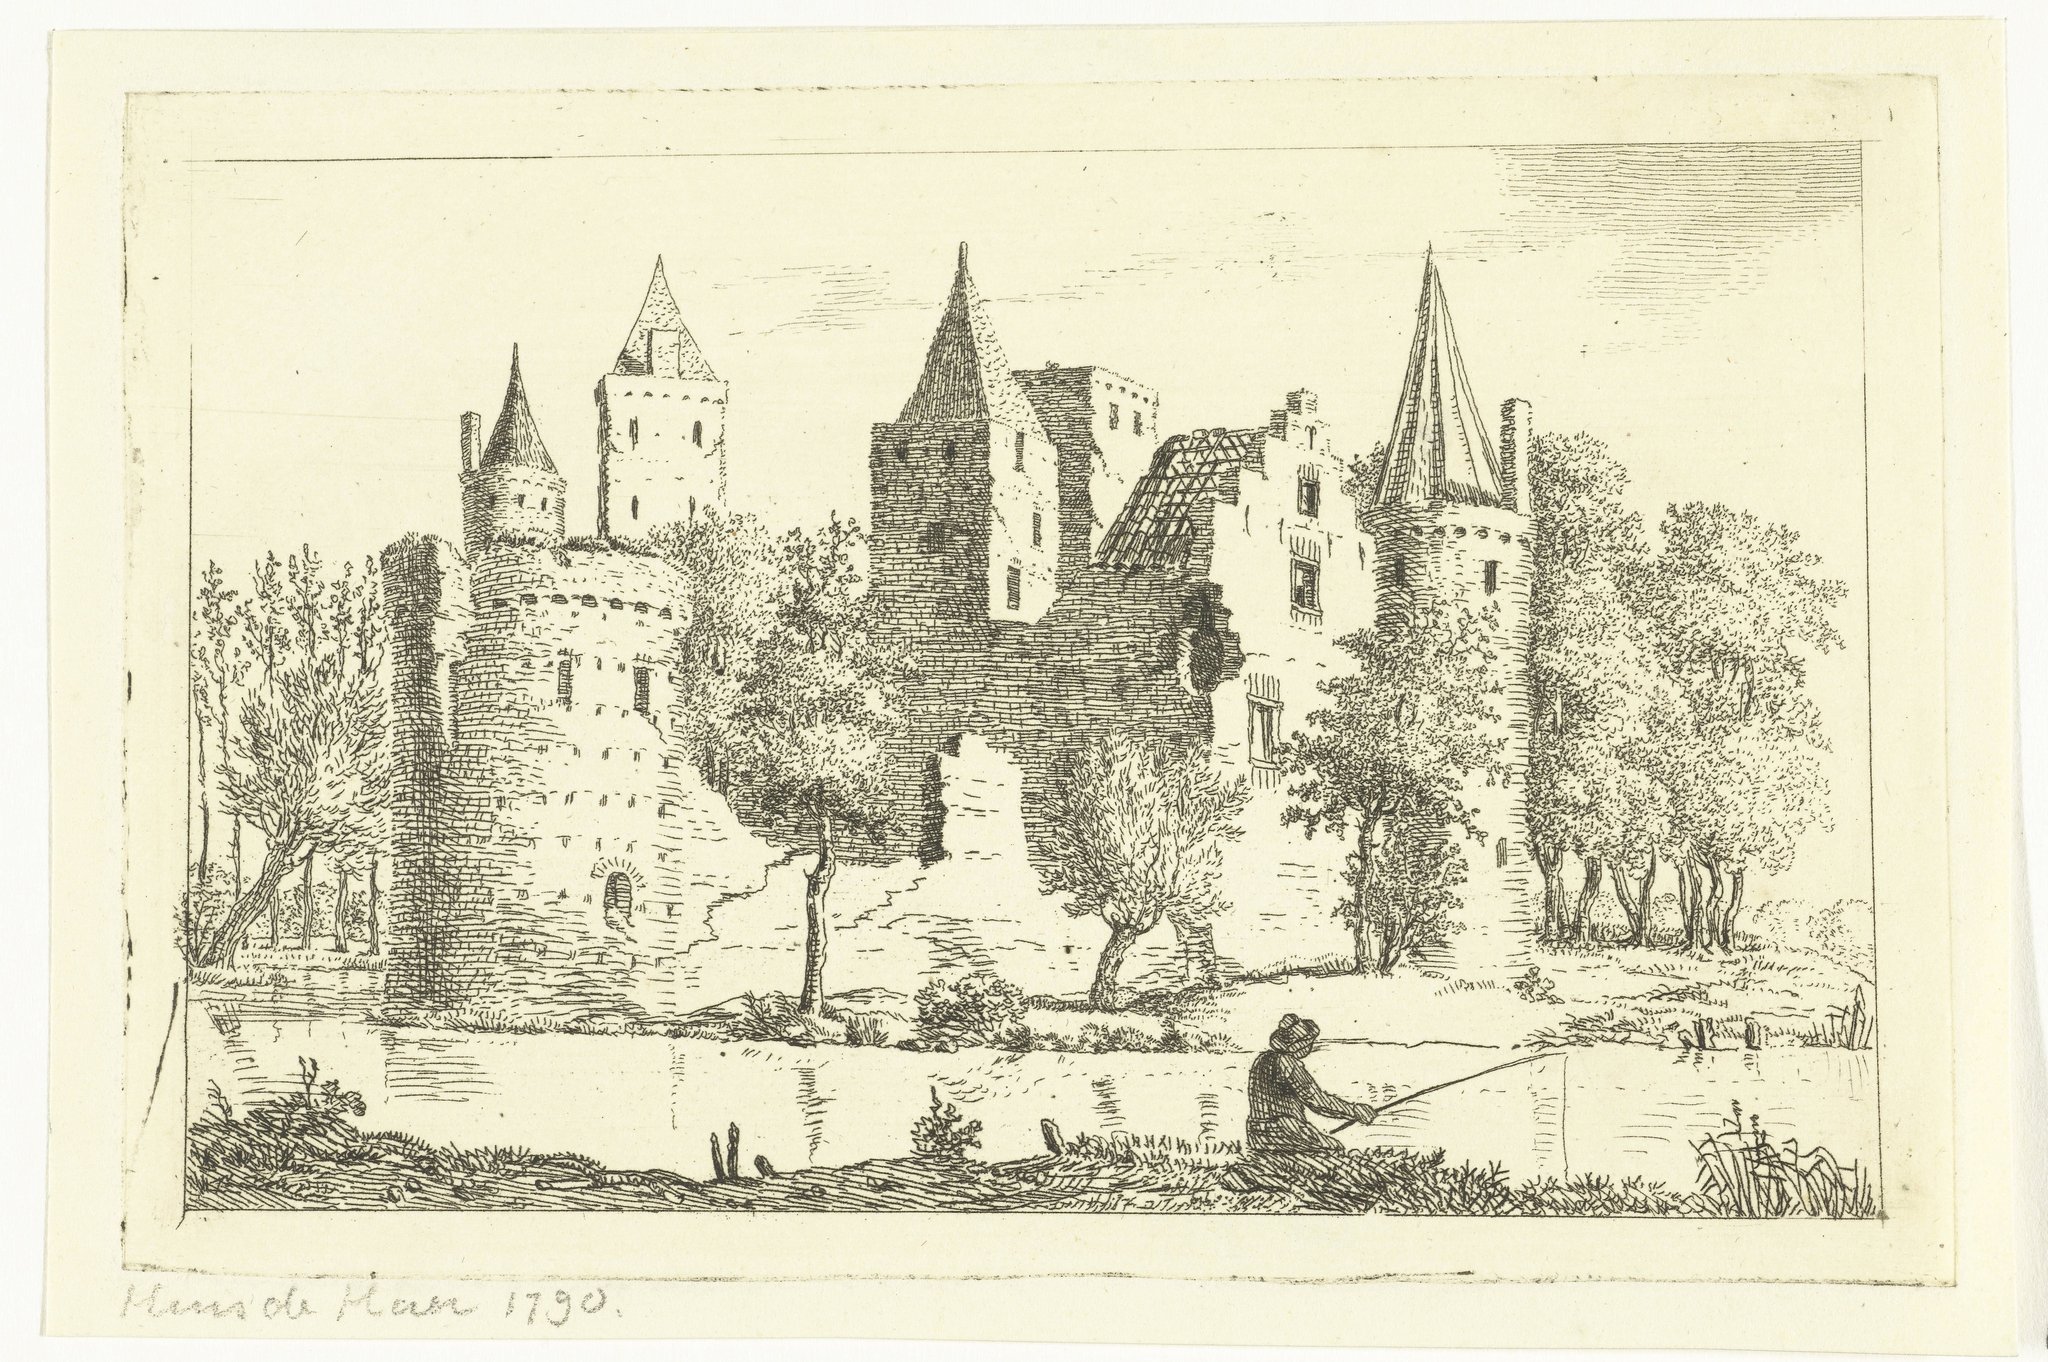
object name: print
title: Ruïne van kasteel de Haar bij Haarzuilens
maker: anthonie van den bos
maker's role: draughtsman, print maker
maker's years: 1763-1838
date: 1790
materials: paper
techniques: etching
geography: netherlands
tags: castle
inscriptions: collector's mark: Lugt 2228, inscription: ‘Huis de Haer 1790’